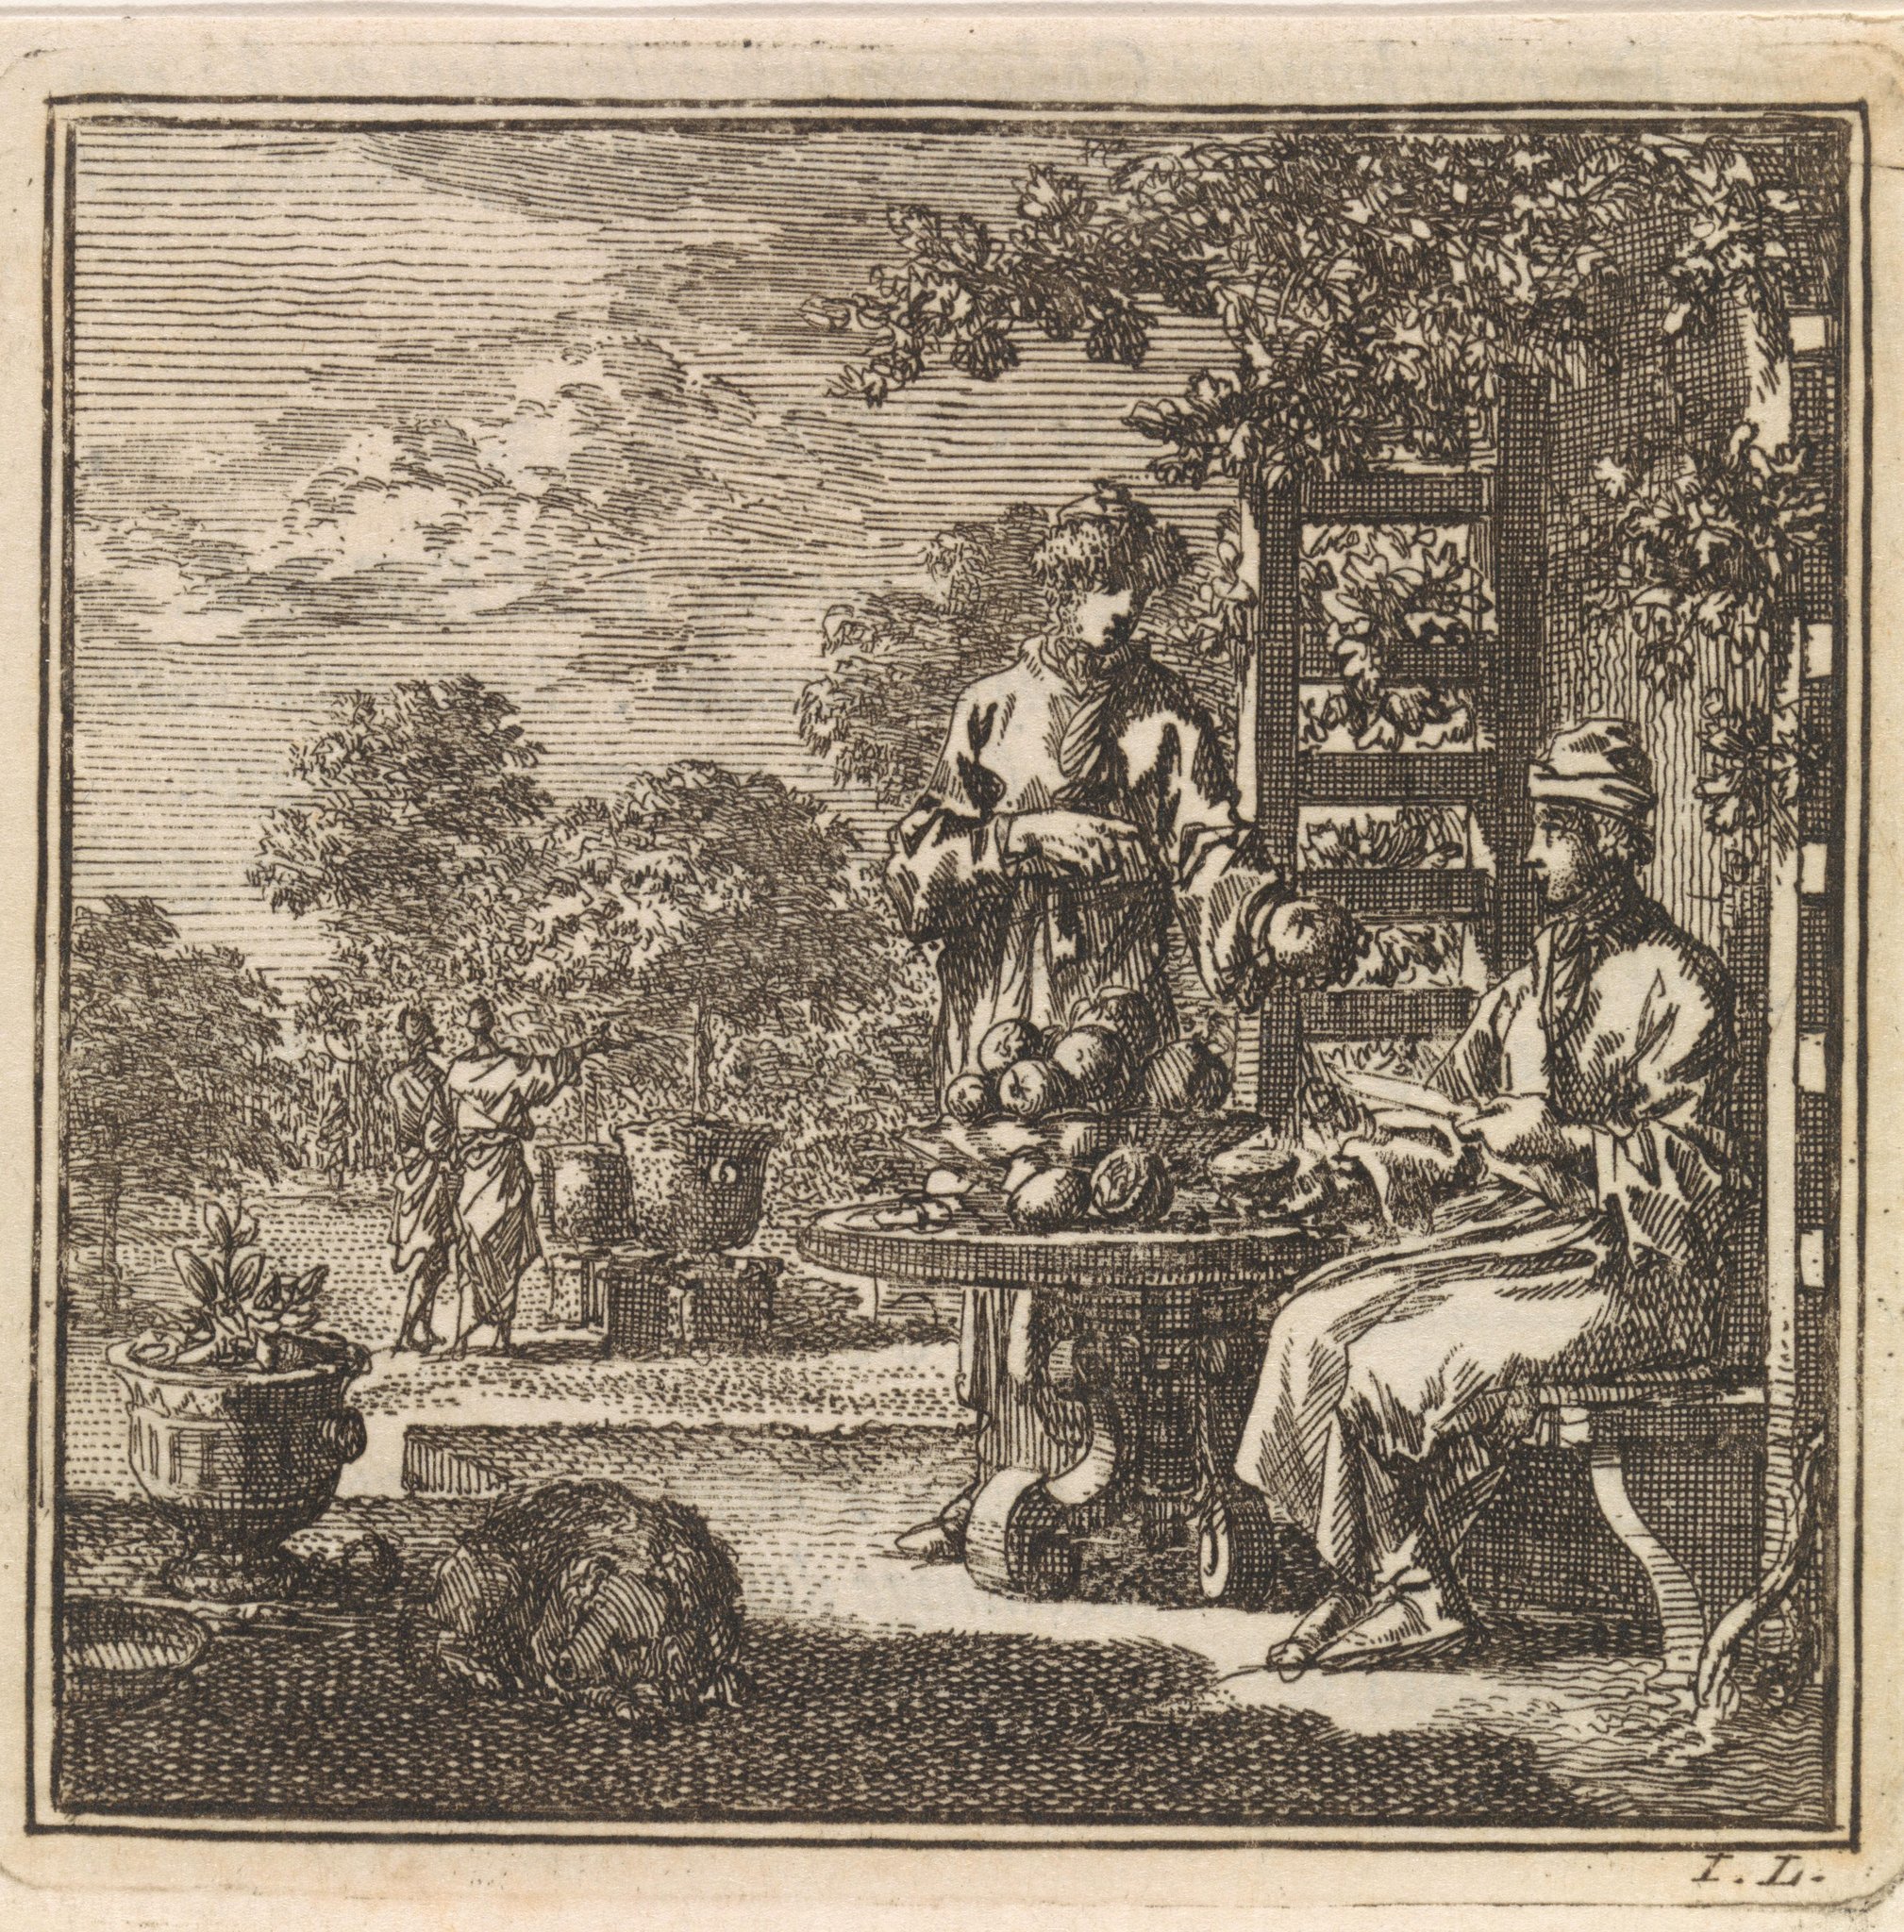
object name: print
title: Gezicht op een tuin waar twee mannen sinaasappels bekijken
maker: jan luyken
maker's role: draughtsman, print maker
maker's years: 1649-1712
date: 1711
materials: paper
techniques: etching, letterpress printing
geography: amsterdam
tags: garden, fruits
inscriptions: collector's mark: Lugt 2228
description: Illustratie voor: Luyken, Jan. De Bykorf des Gemoeds. Amsterdam: Pieter Arentsz. II (wed.) en Cornelis van der Sys, 1711, p. 370.